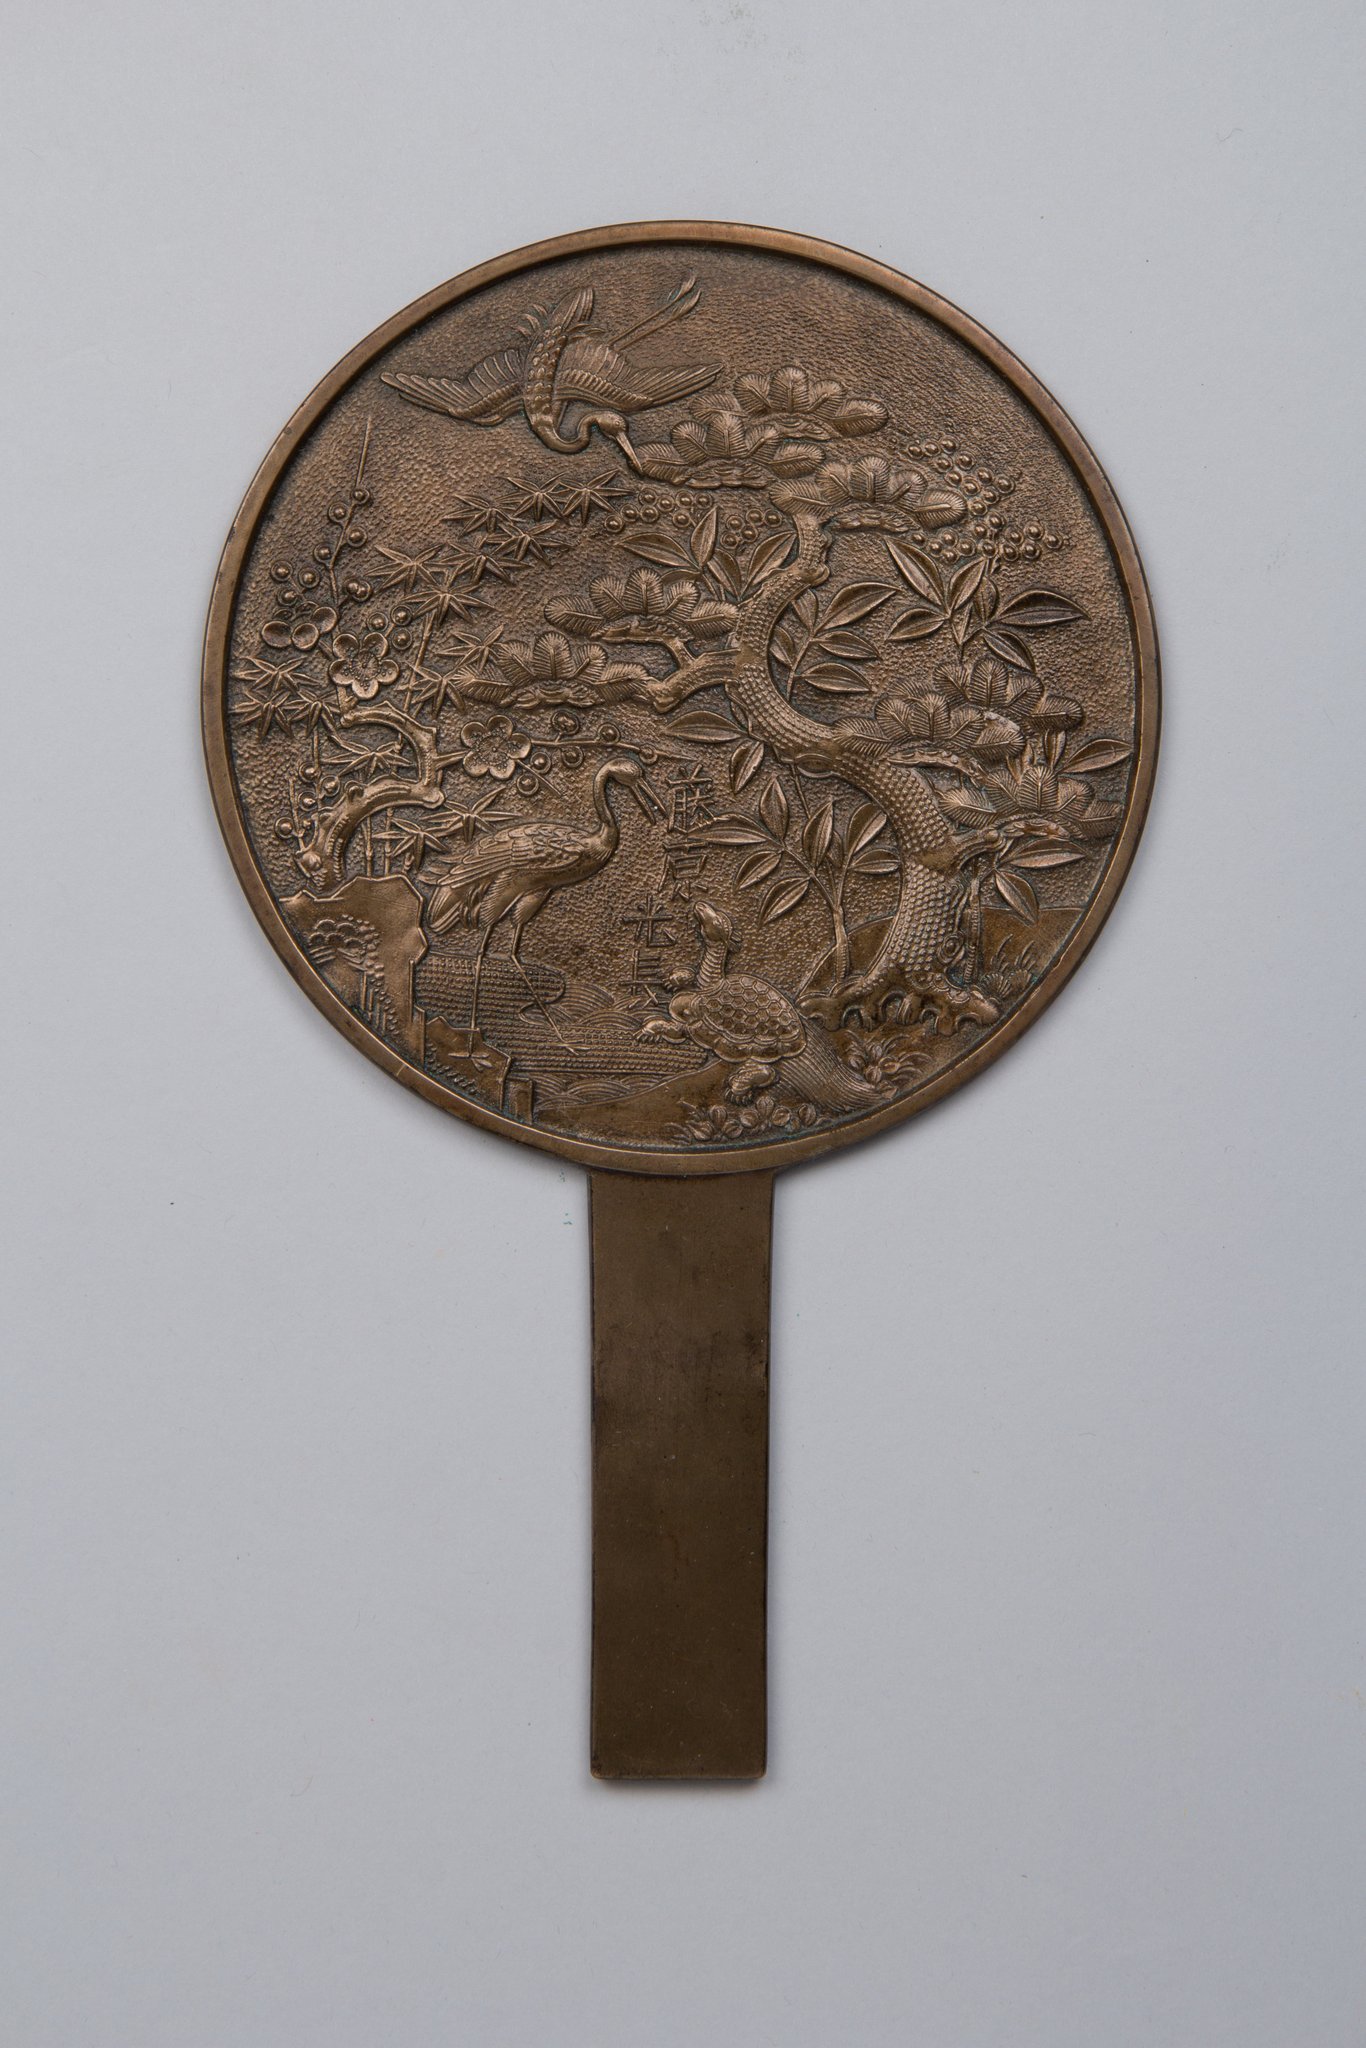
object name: mirror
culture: japanese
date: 1801-1900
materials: bronze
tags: cranes